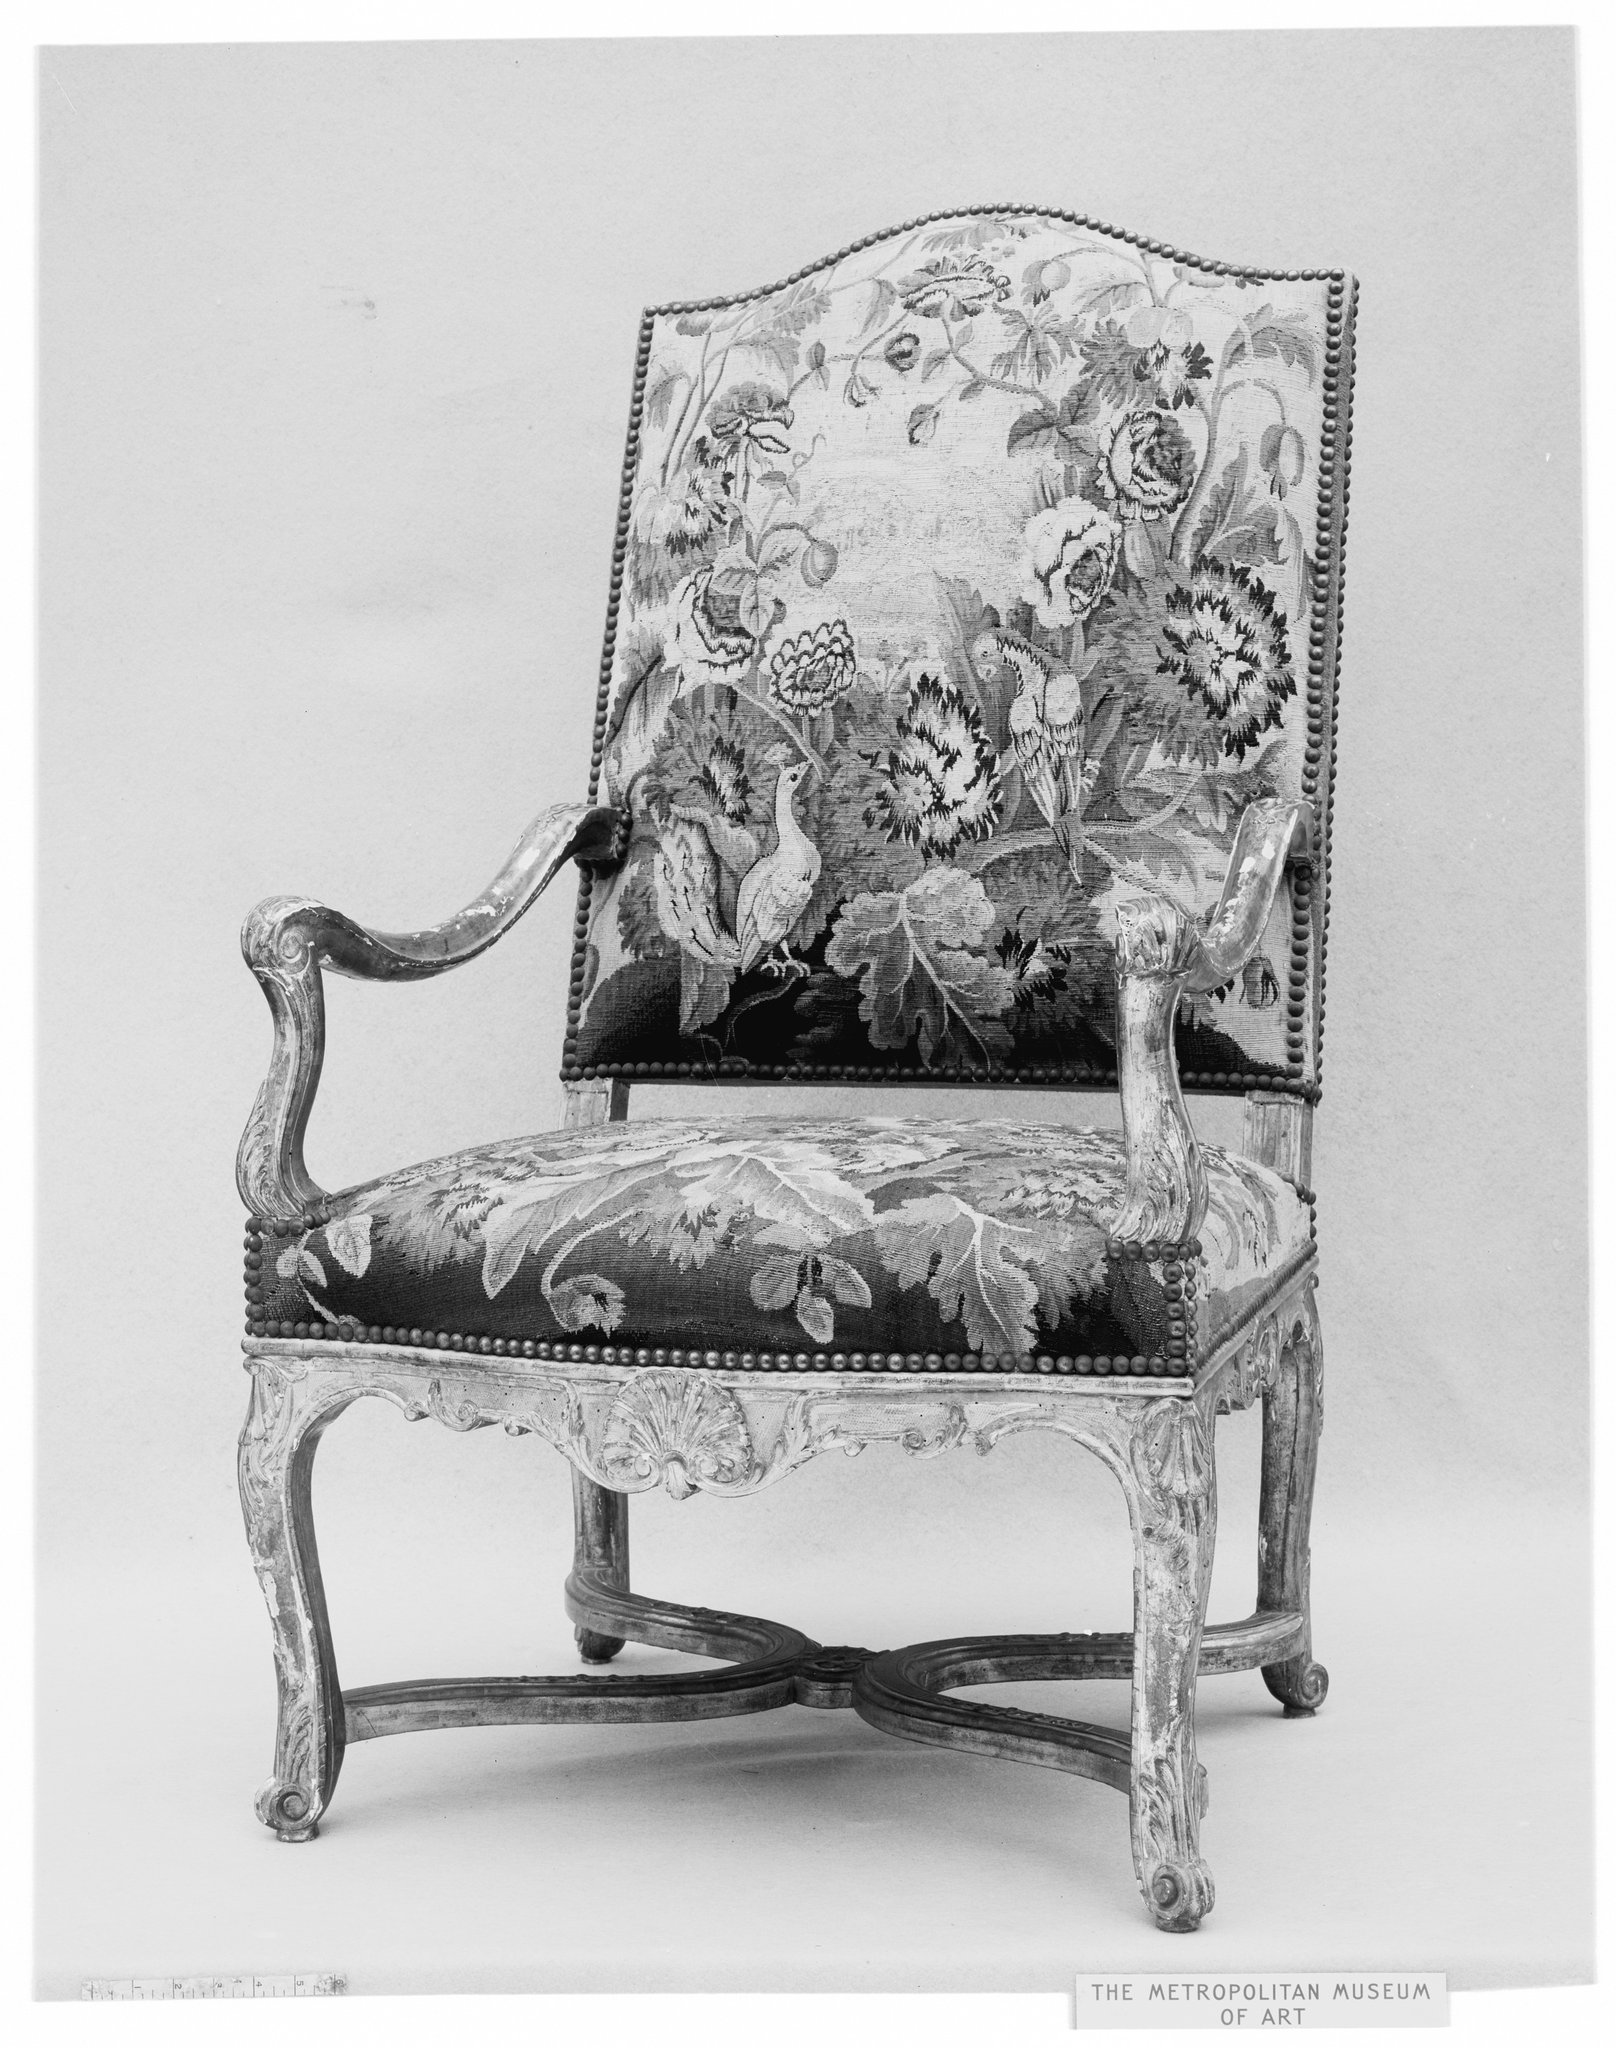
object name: armchair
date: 1667-1733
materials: wood, silk, wool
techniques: carving, gilding, tapestry